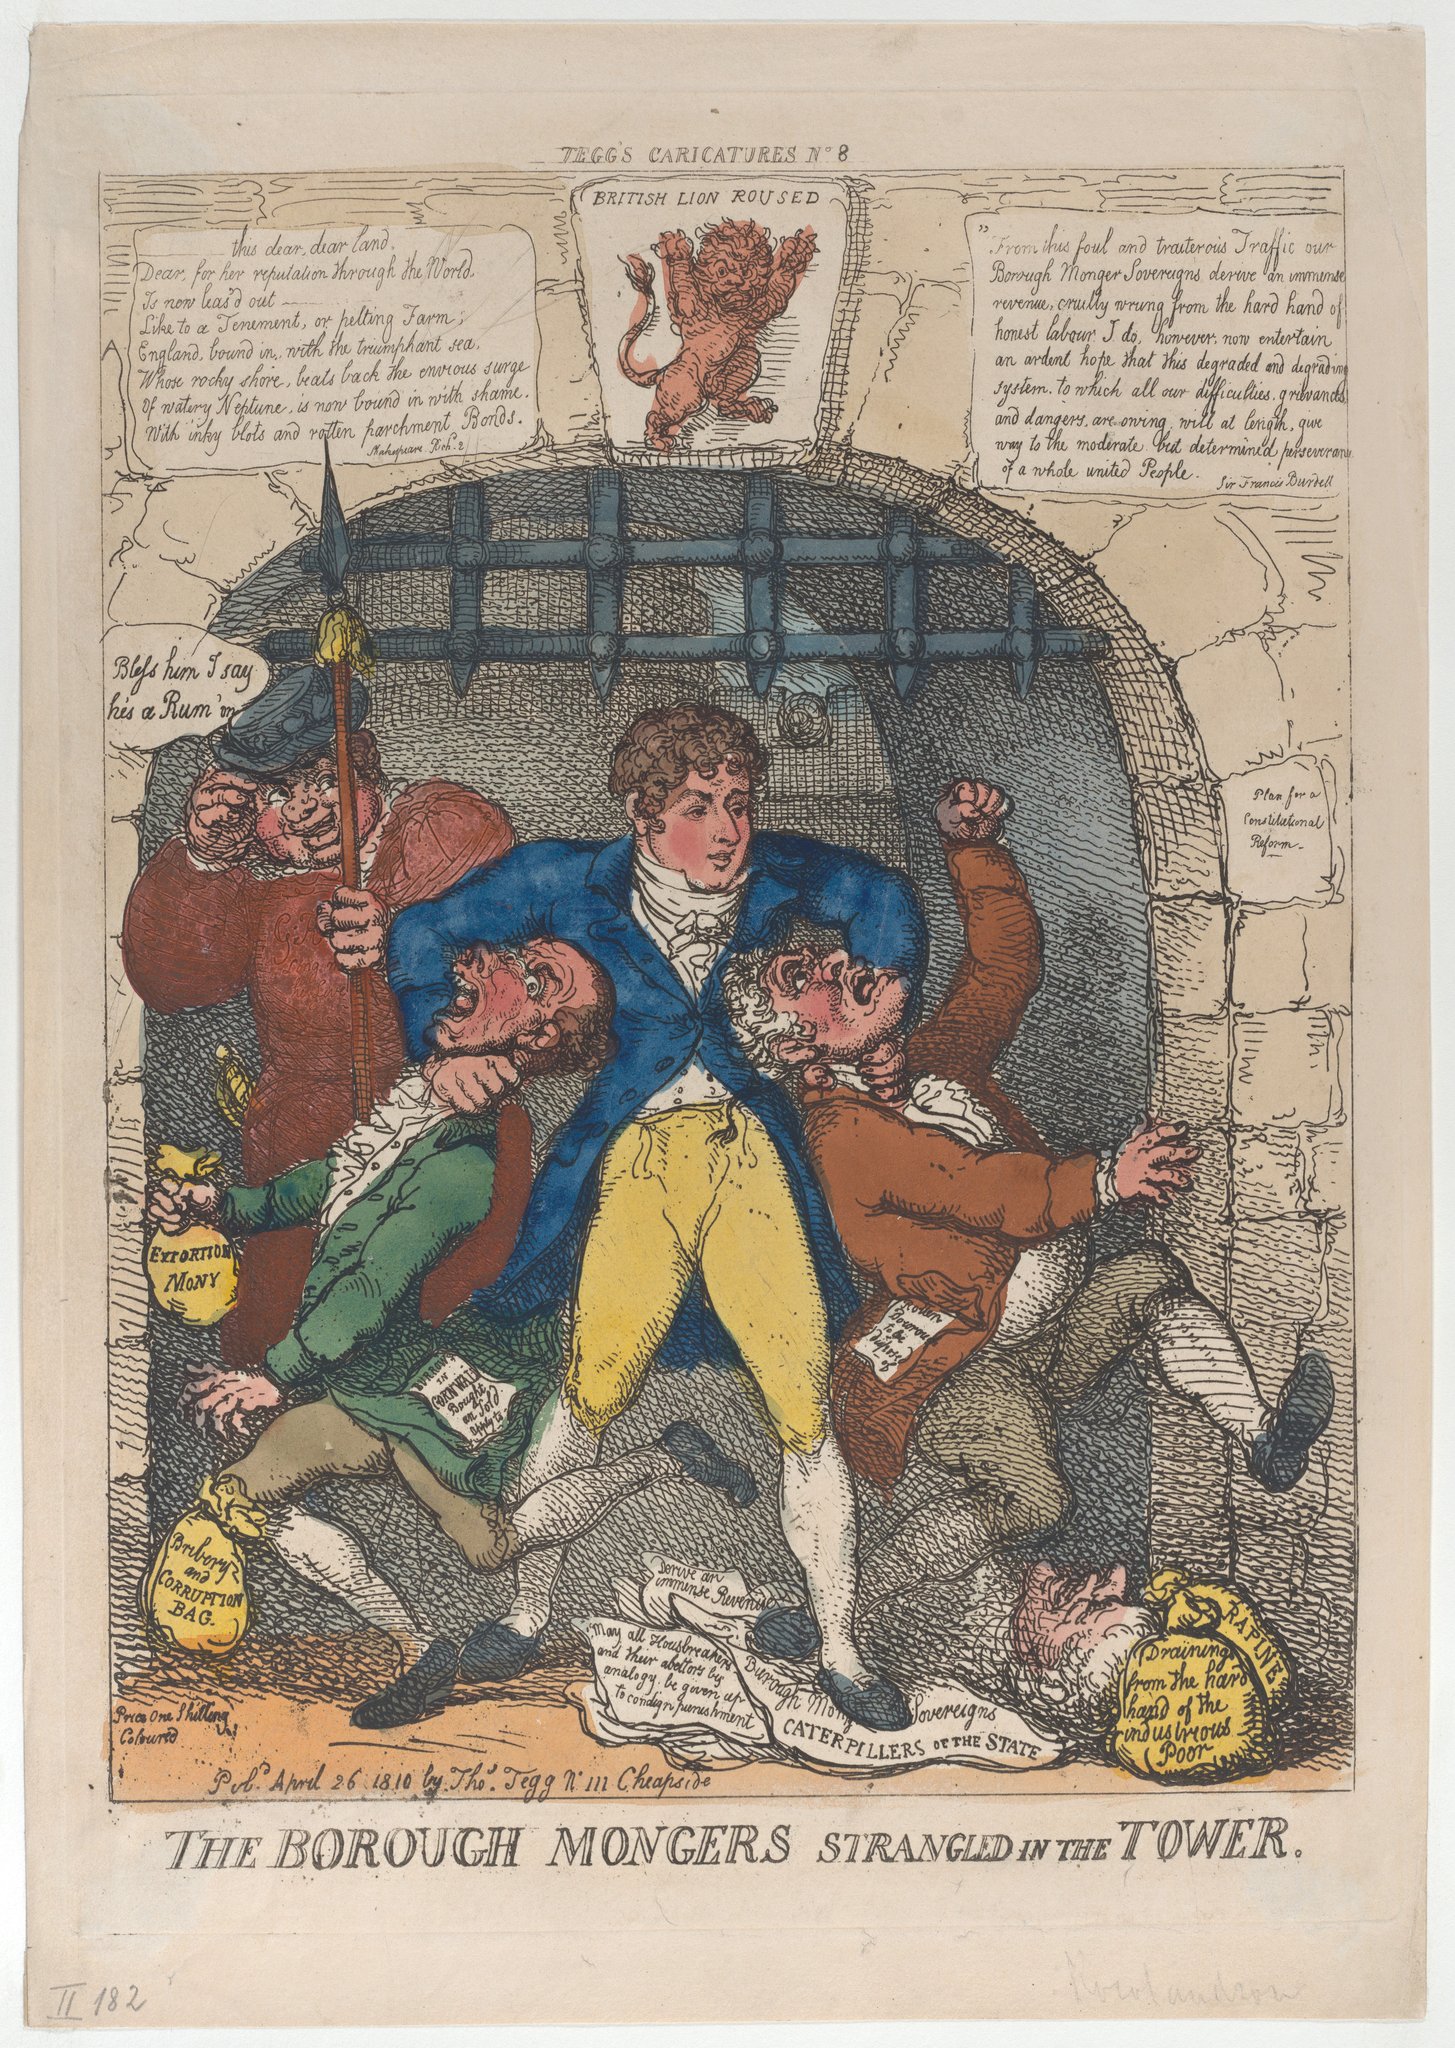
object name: print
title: The Borough Mongers Strangled in the Tower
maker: thomas rowlandson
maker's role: artist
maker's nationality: british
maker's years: 1757-1827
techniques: etching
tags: satire,men